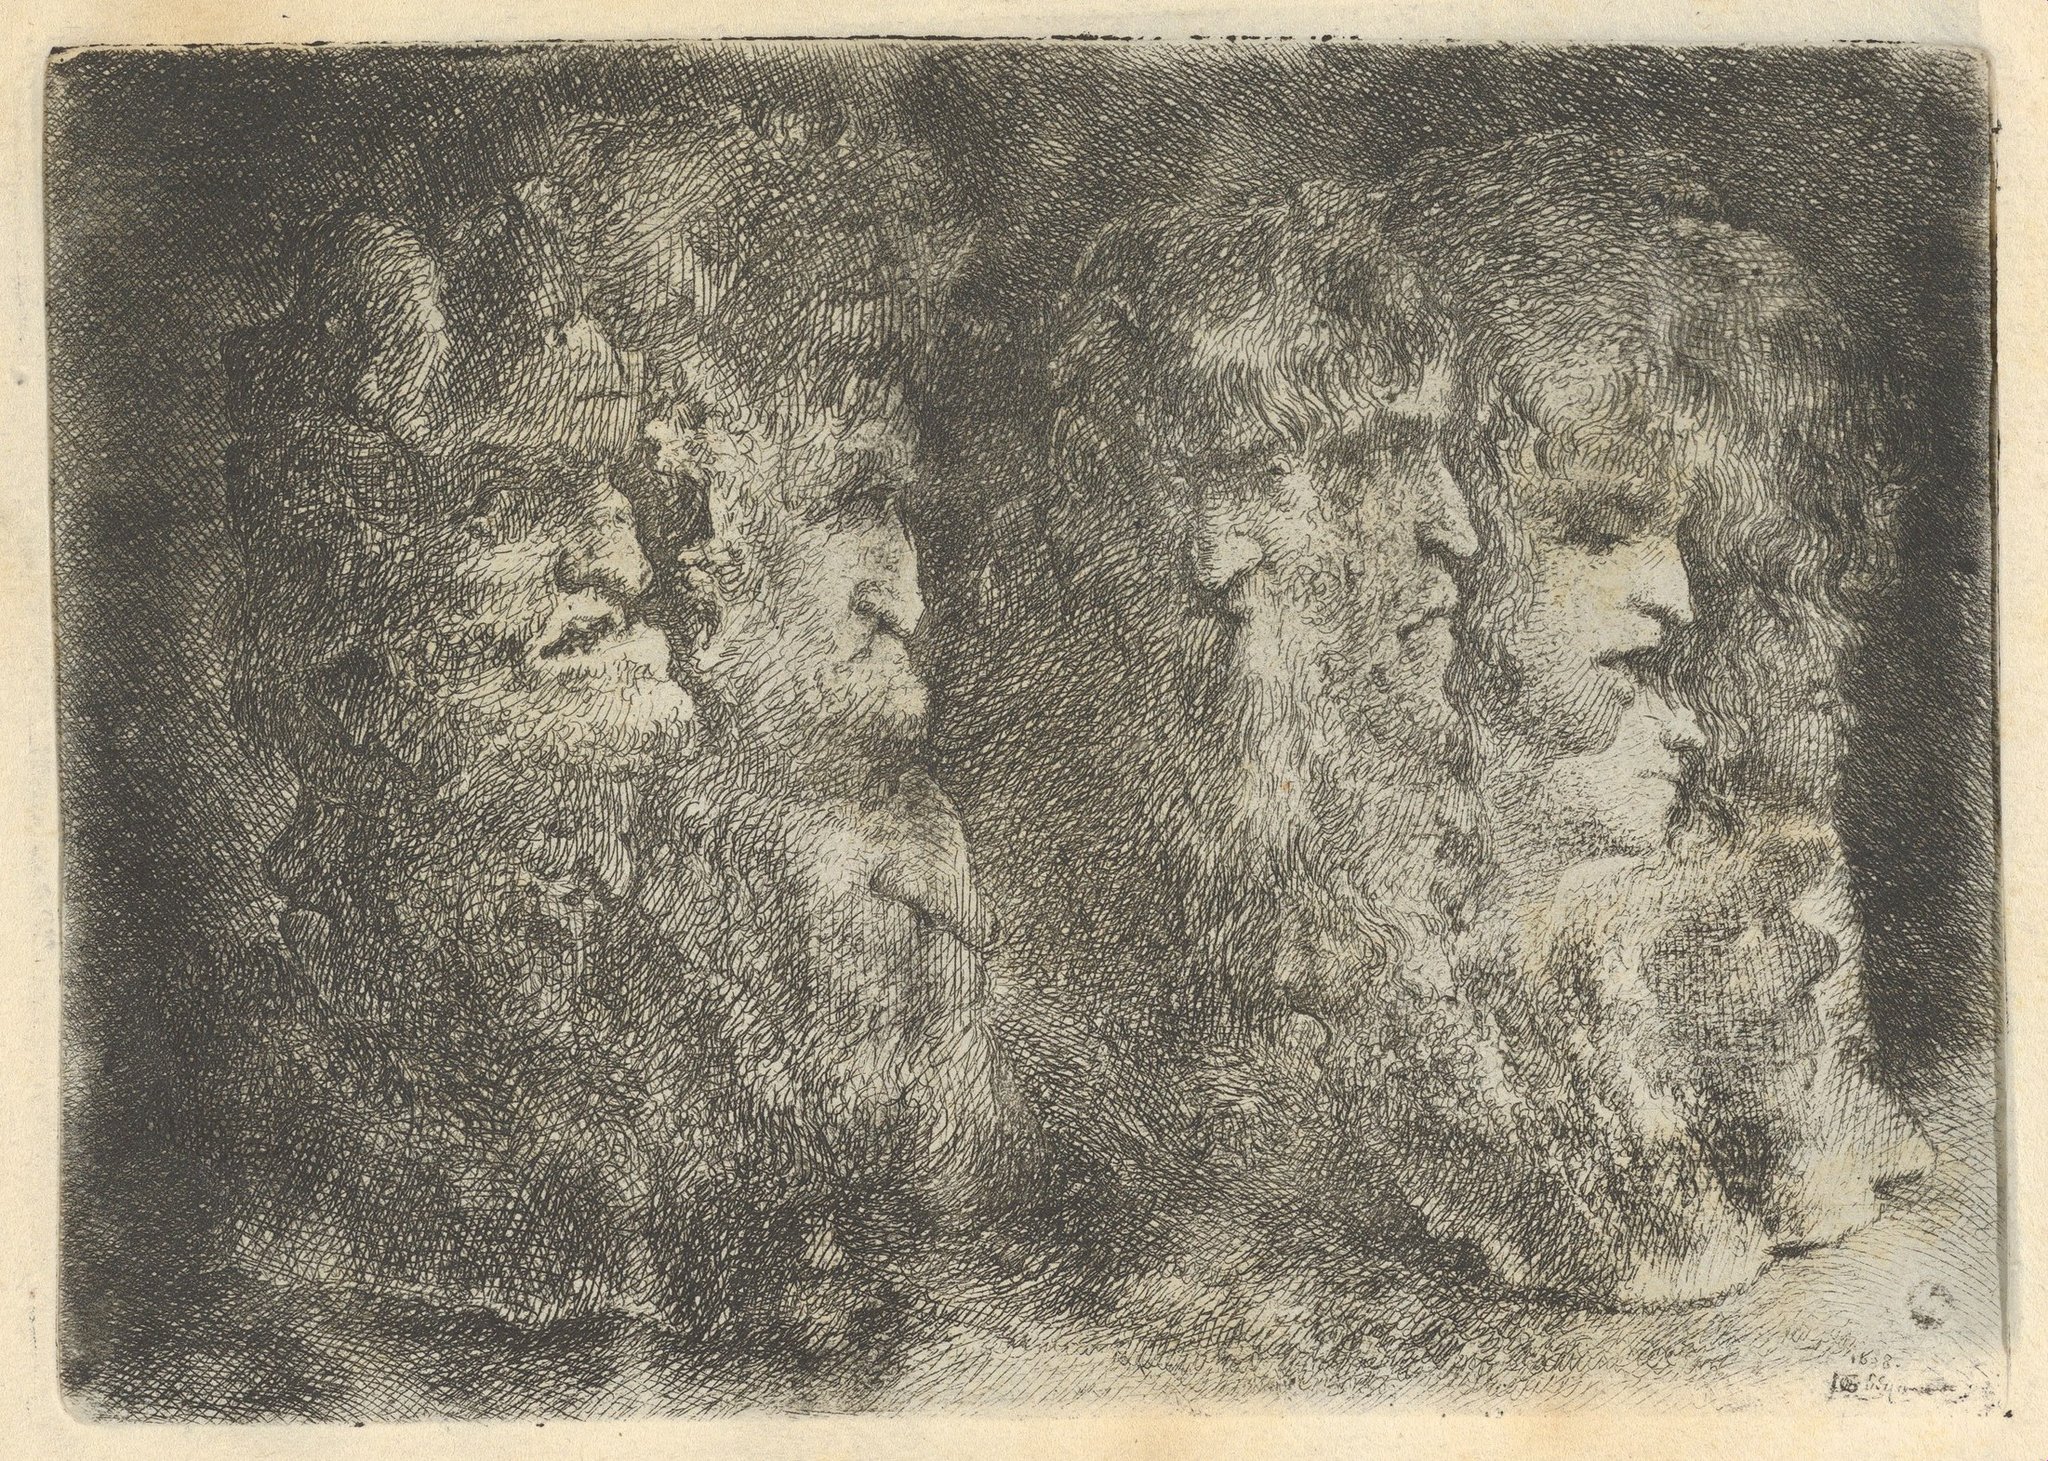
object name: etching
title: Two Formations of Grotesque Heads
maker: jacques de gheyn iii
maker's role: artist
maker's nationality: dutch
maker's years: 1596-1641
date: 1638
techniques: etching, printing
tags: heads